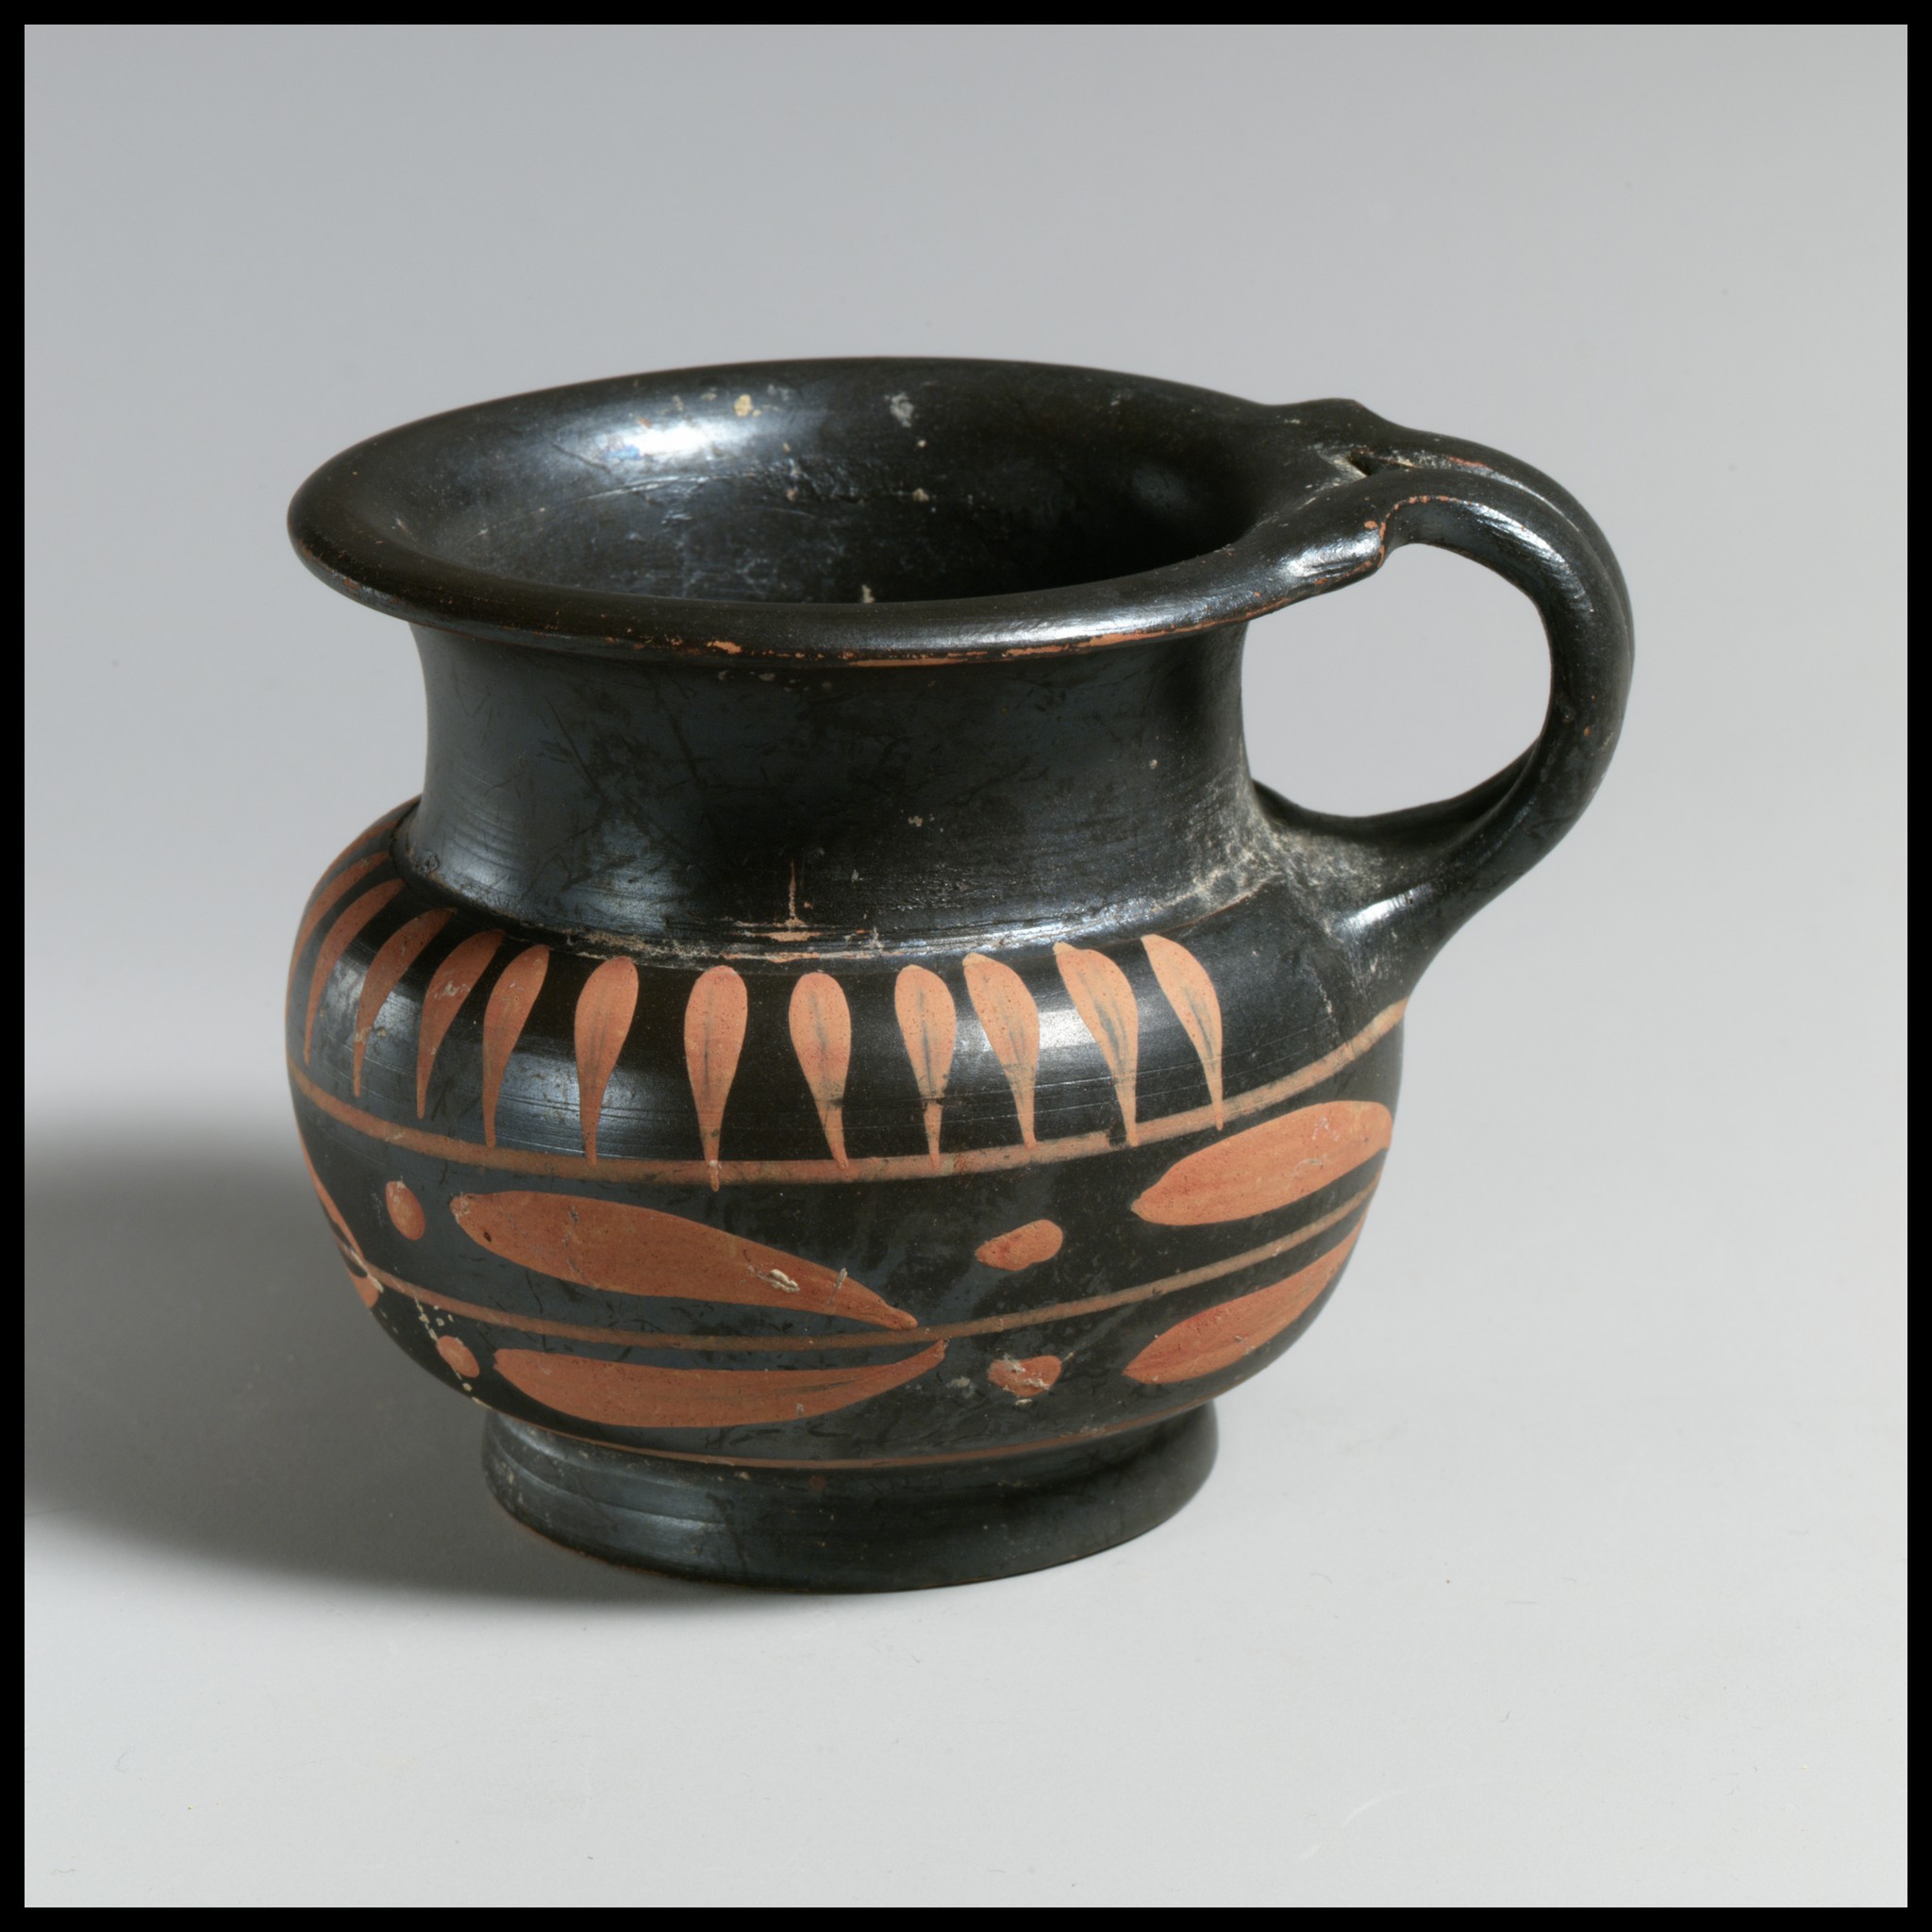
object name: mug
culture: greek, south italian, apulian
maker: xenon group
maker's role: artist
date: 400-301 BCE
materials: terracotta